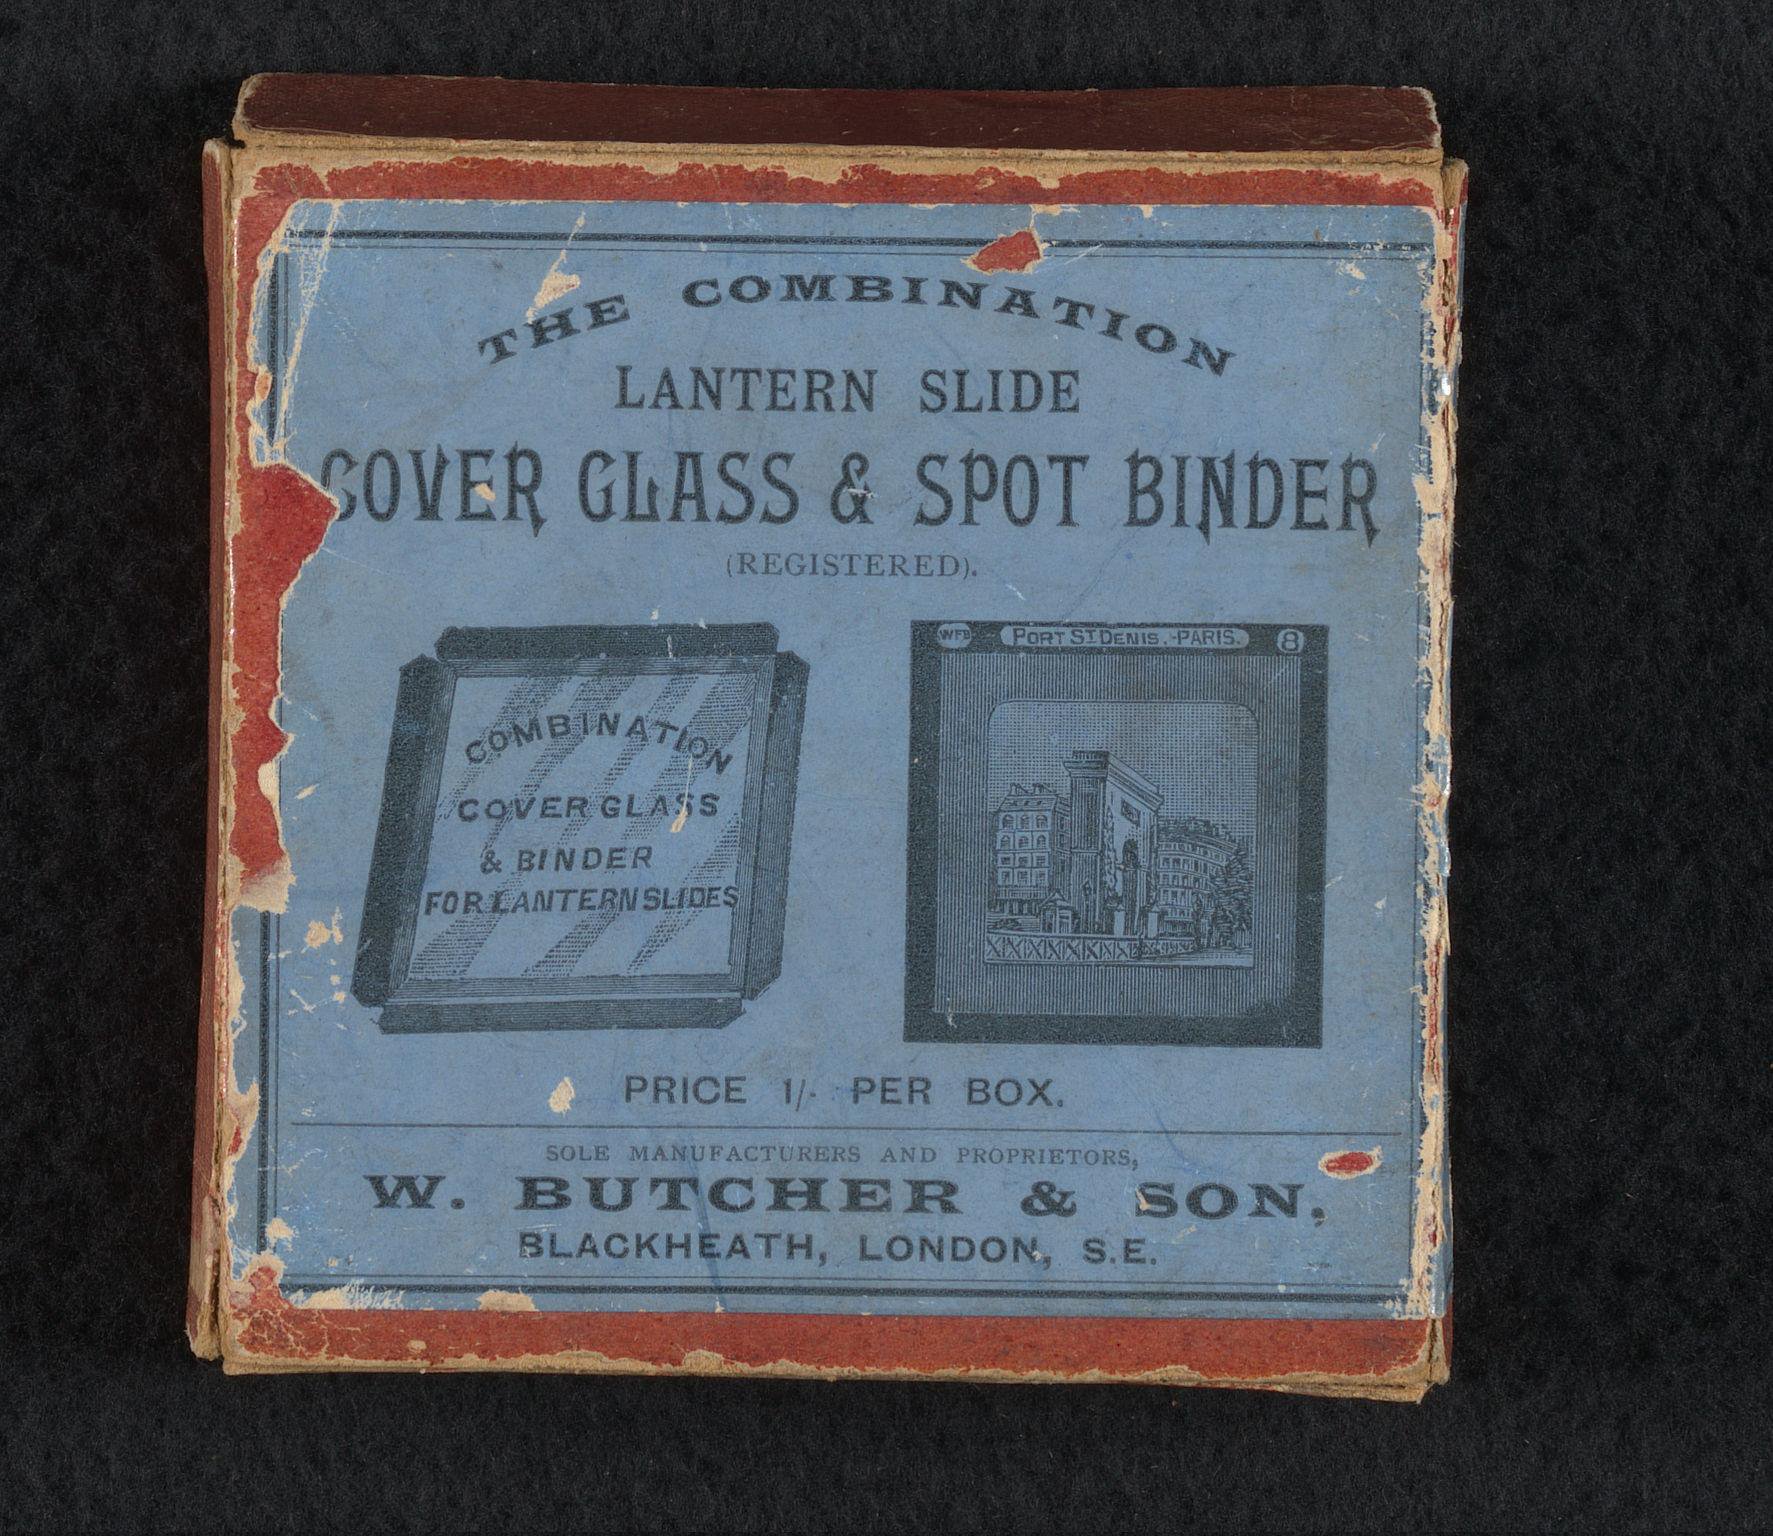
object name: glass negative stereograph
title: 1 leeg doosje W.Butcher & Son lantaarnplaatjes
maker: machiel gerrit george suyver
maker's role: fotograaf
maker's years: 1872-1933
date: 1890-1898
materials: glass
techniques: gelatin glass negative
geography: netherlands